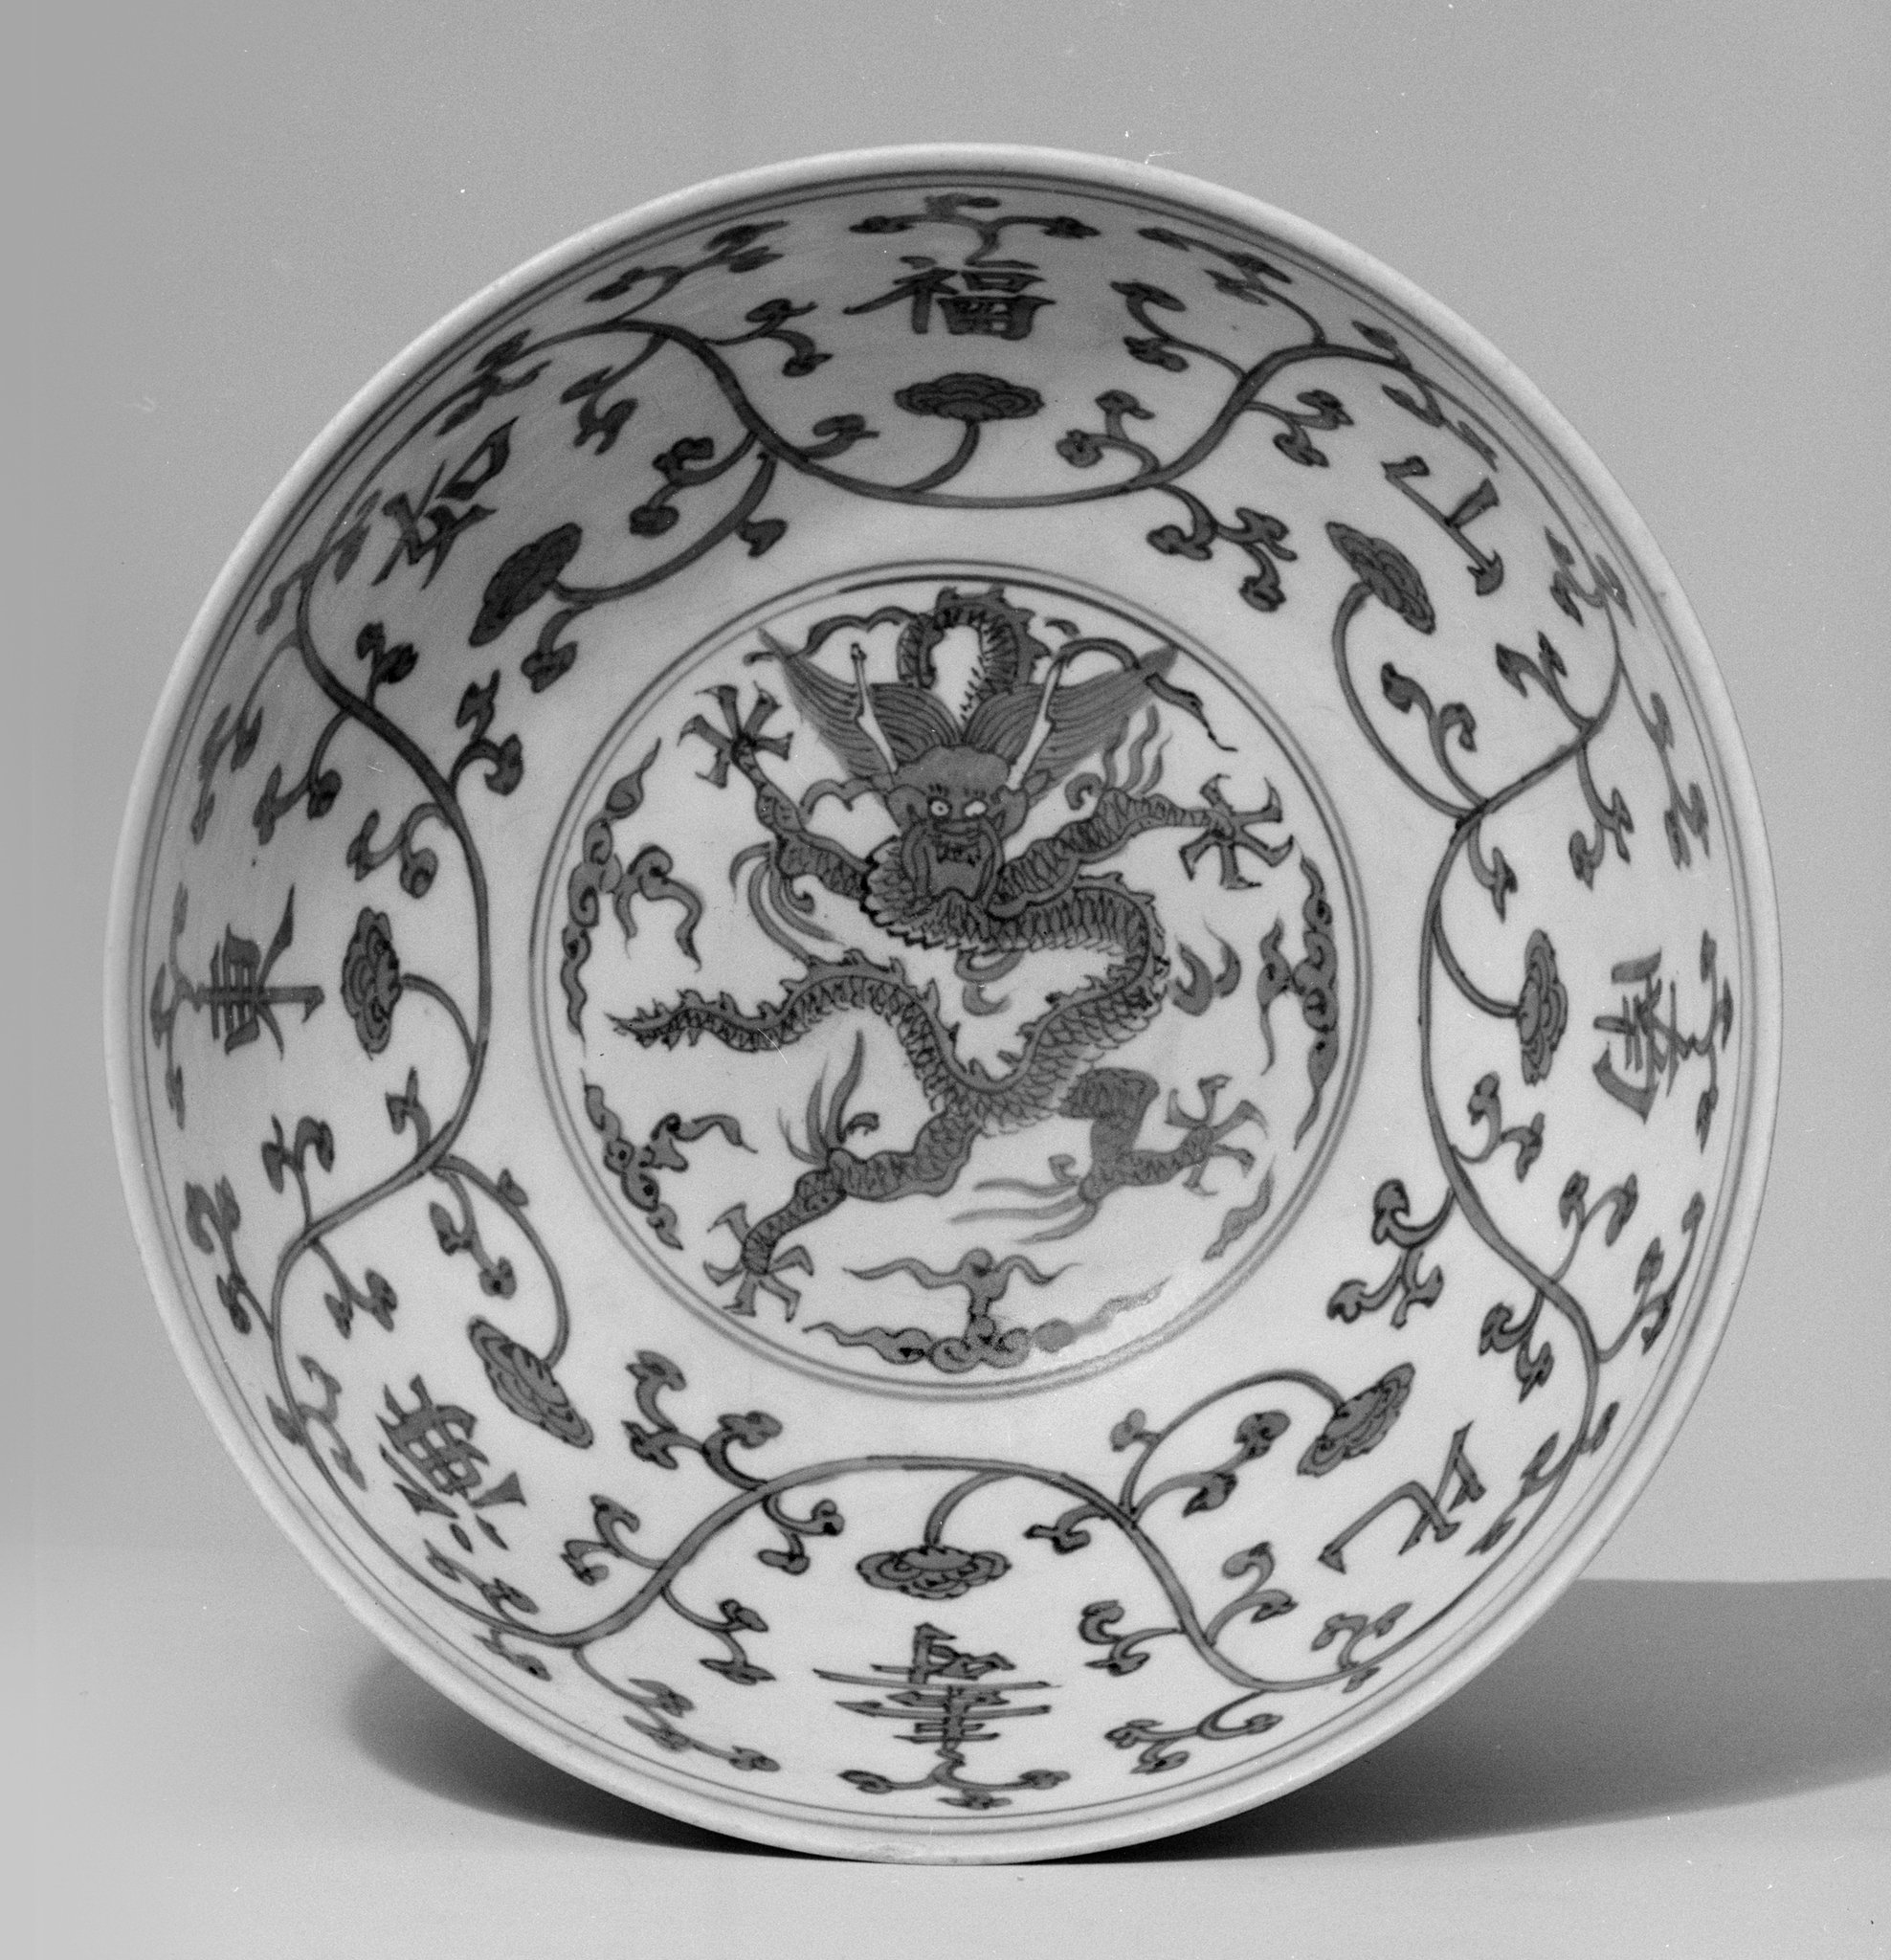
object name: bowl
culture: chinese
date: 1573-1620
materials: porcelain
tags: dragons